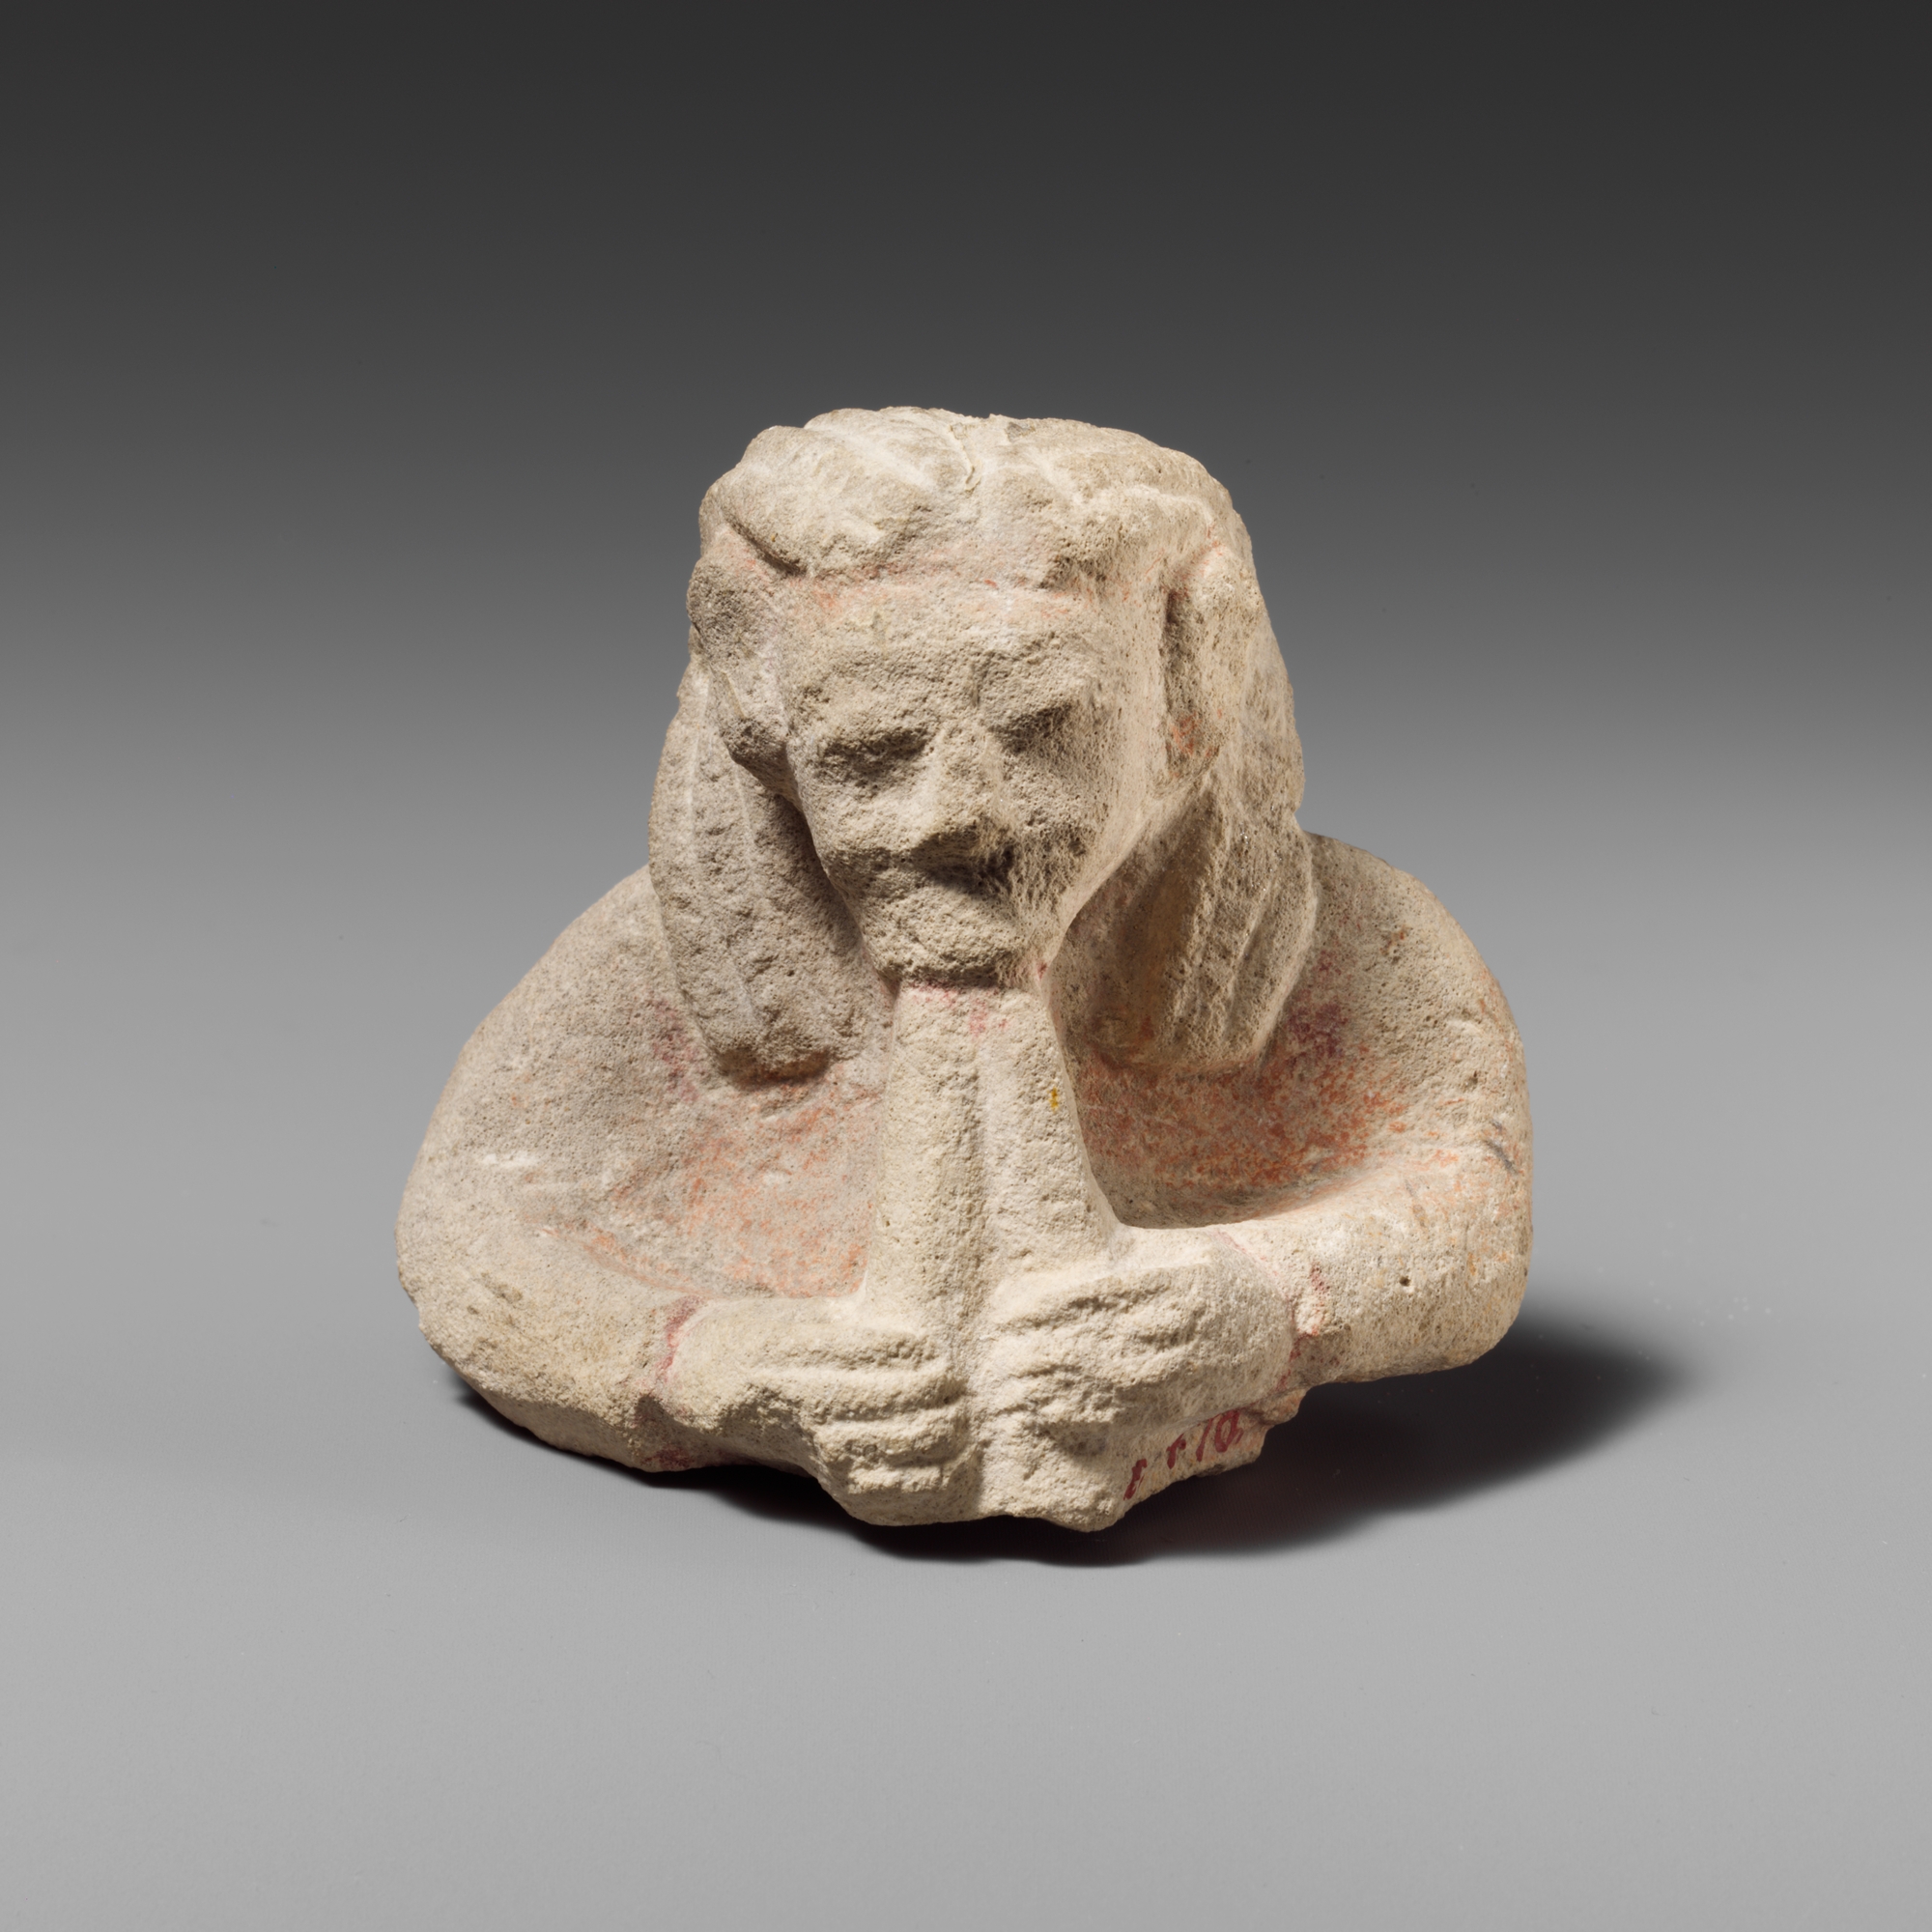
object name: statuette of a flute player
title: Upper part of a limestone male aulos player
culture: cypriot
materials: limestone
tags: musical instruments,men,music,musicians